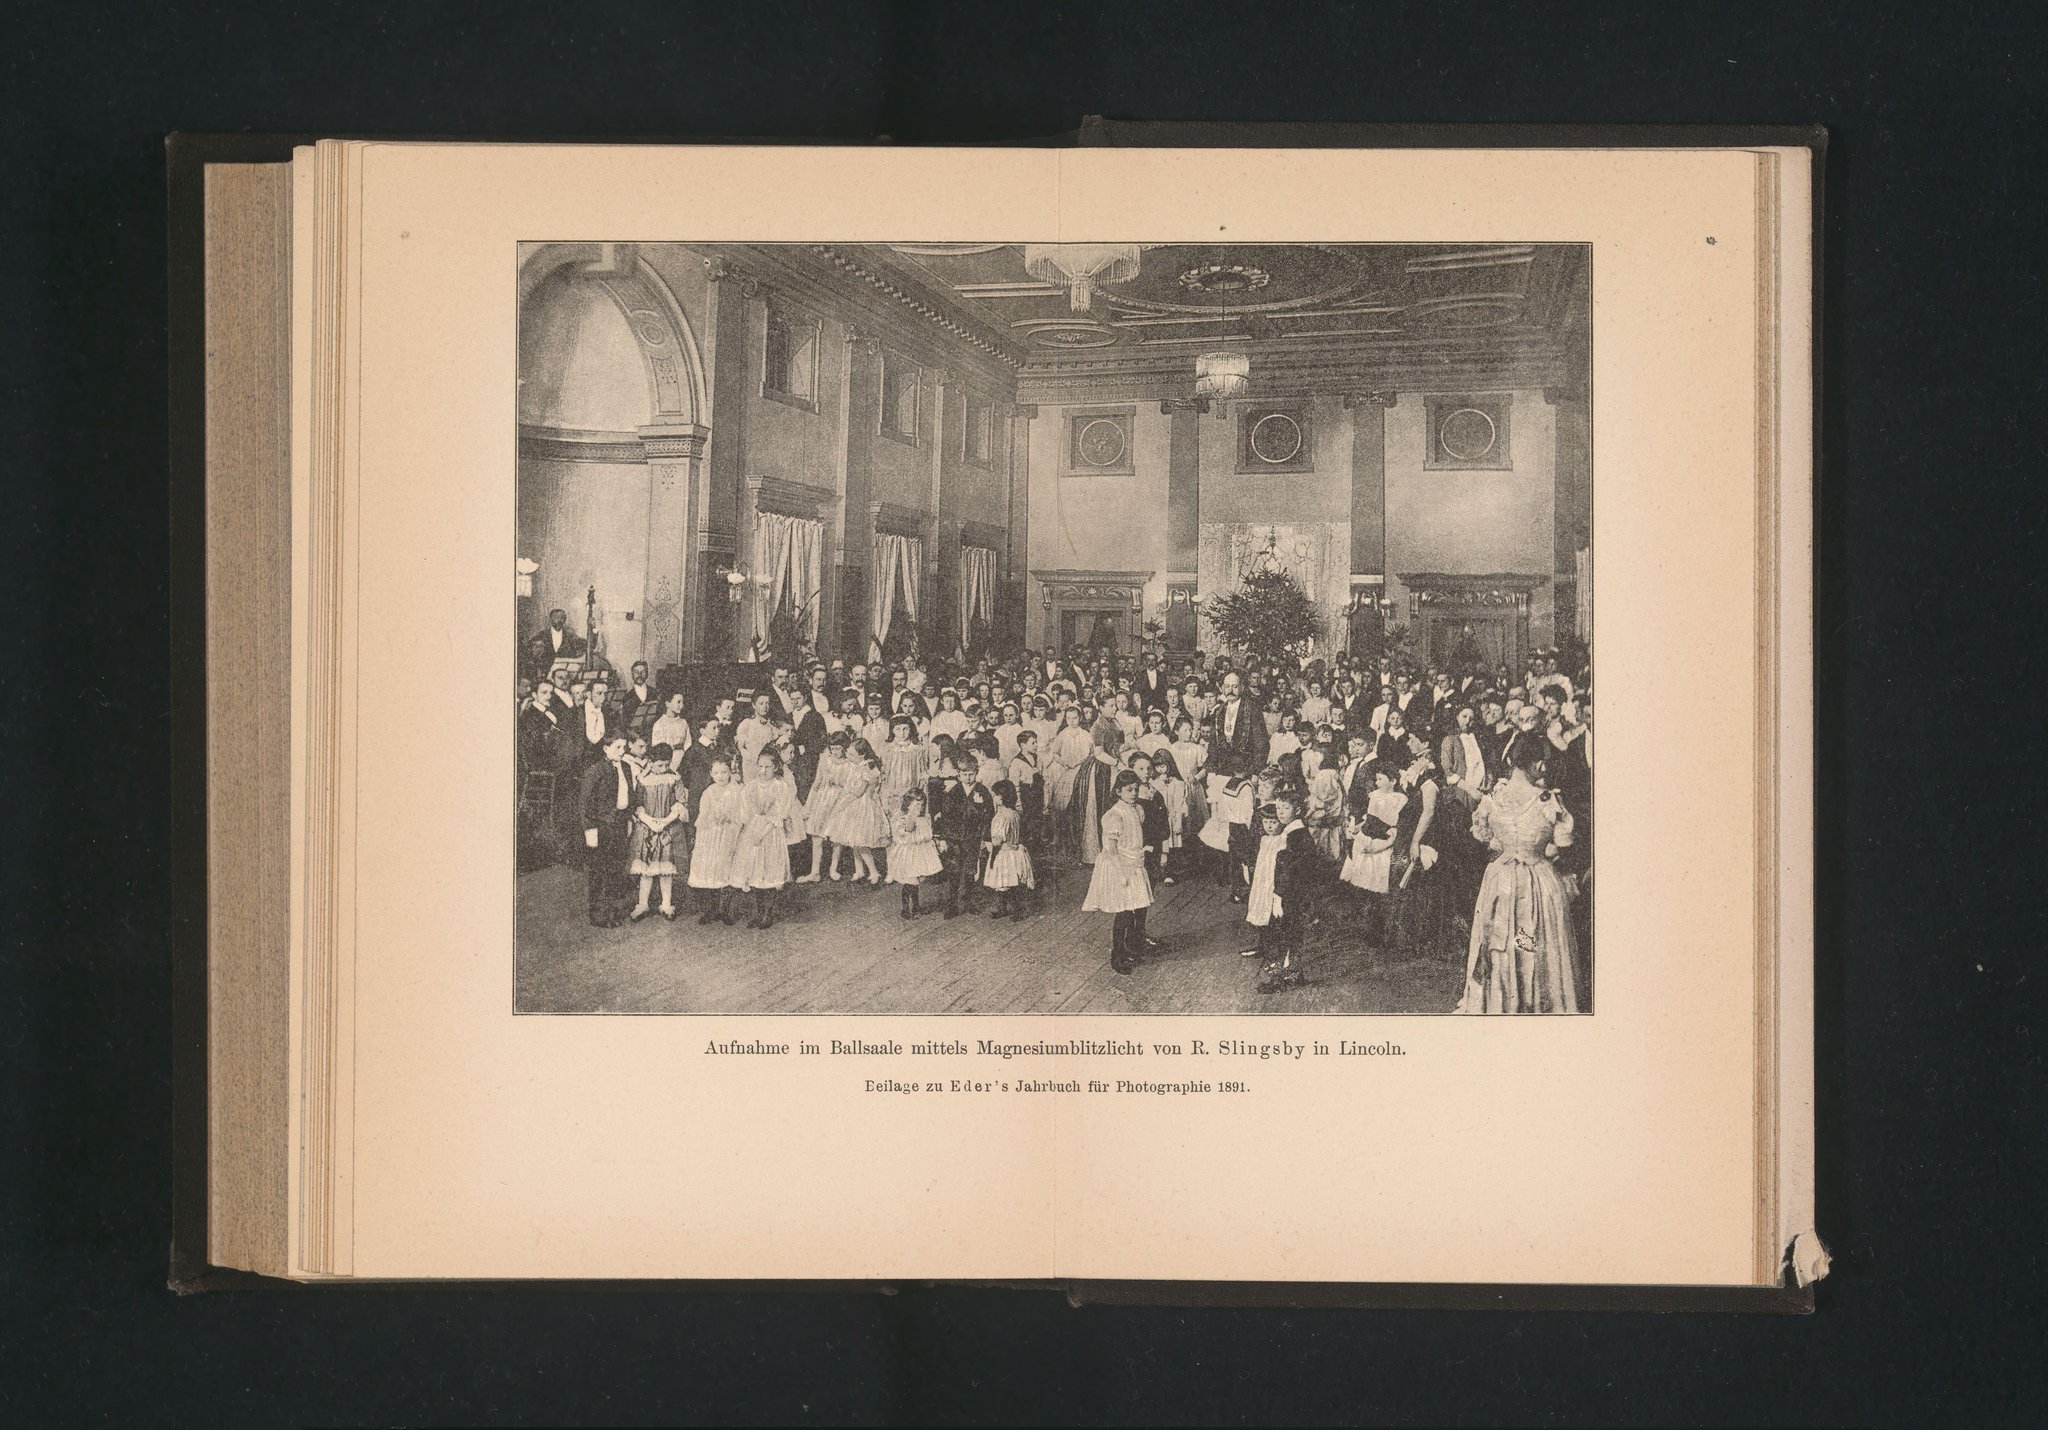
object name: page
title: Balzaal met onbekende groep mensen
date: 1886-1891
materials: paper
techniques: autotype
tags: night-club, dance-hall, anonymous historical persons portrayed in a group, in a group-portrait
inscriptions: inscription: ‘Beilage zu Eder's Jahbruch für Photographie 1891’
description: Prent op zeven- en achtentwintigste ongenummerde pagina na pagina 627.